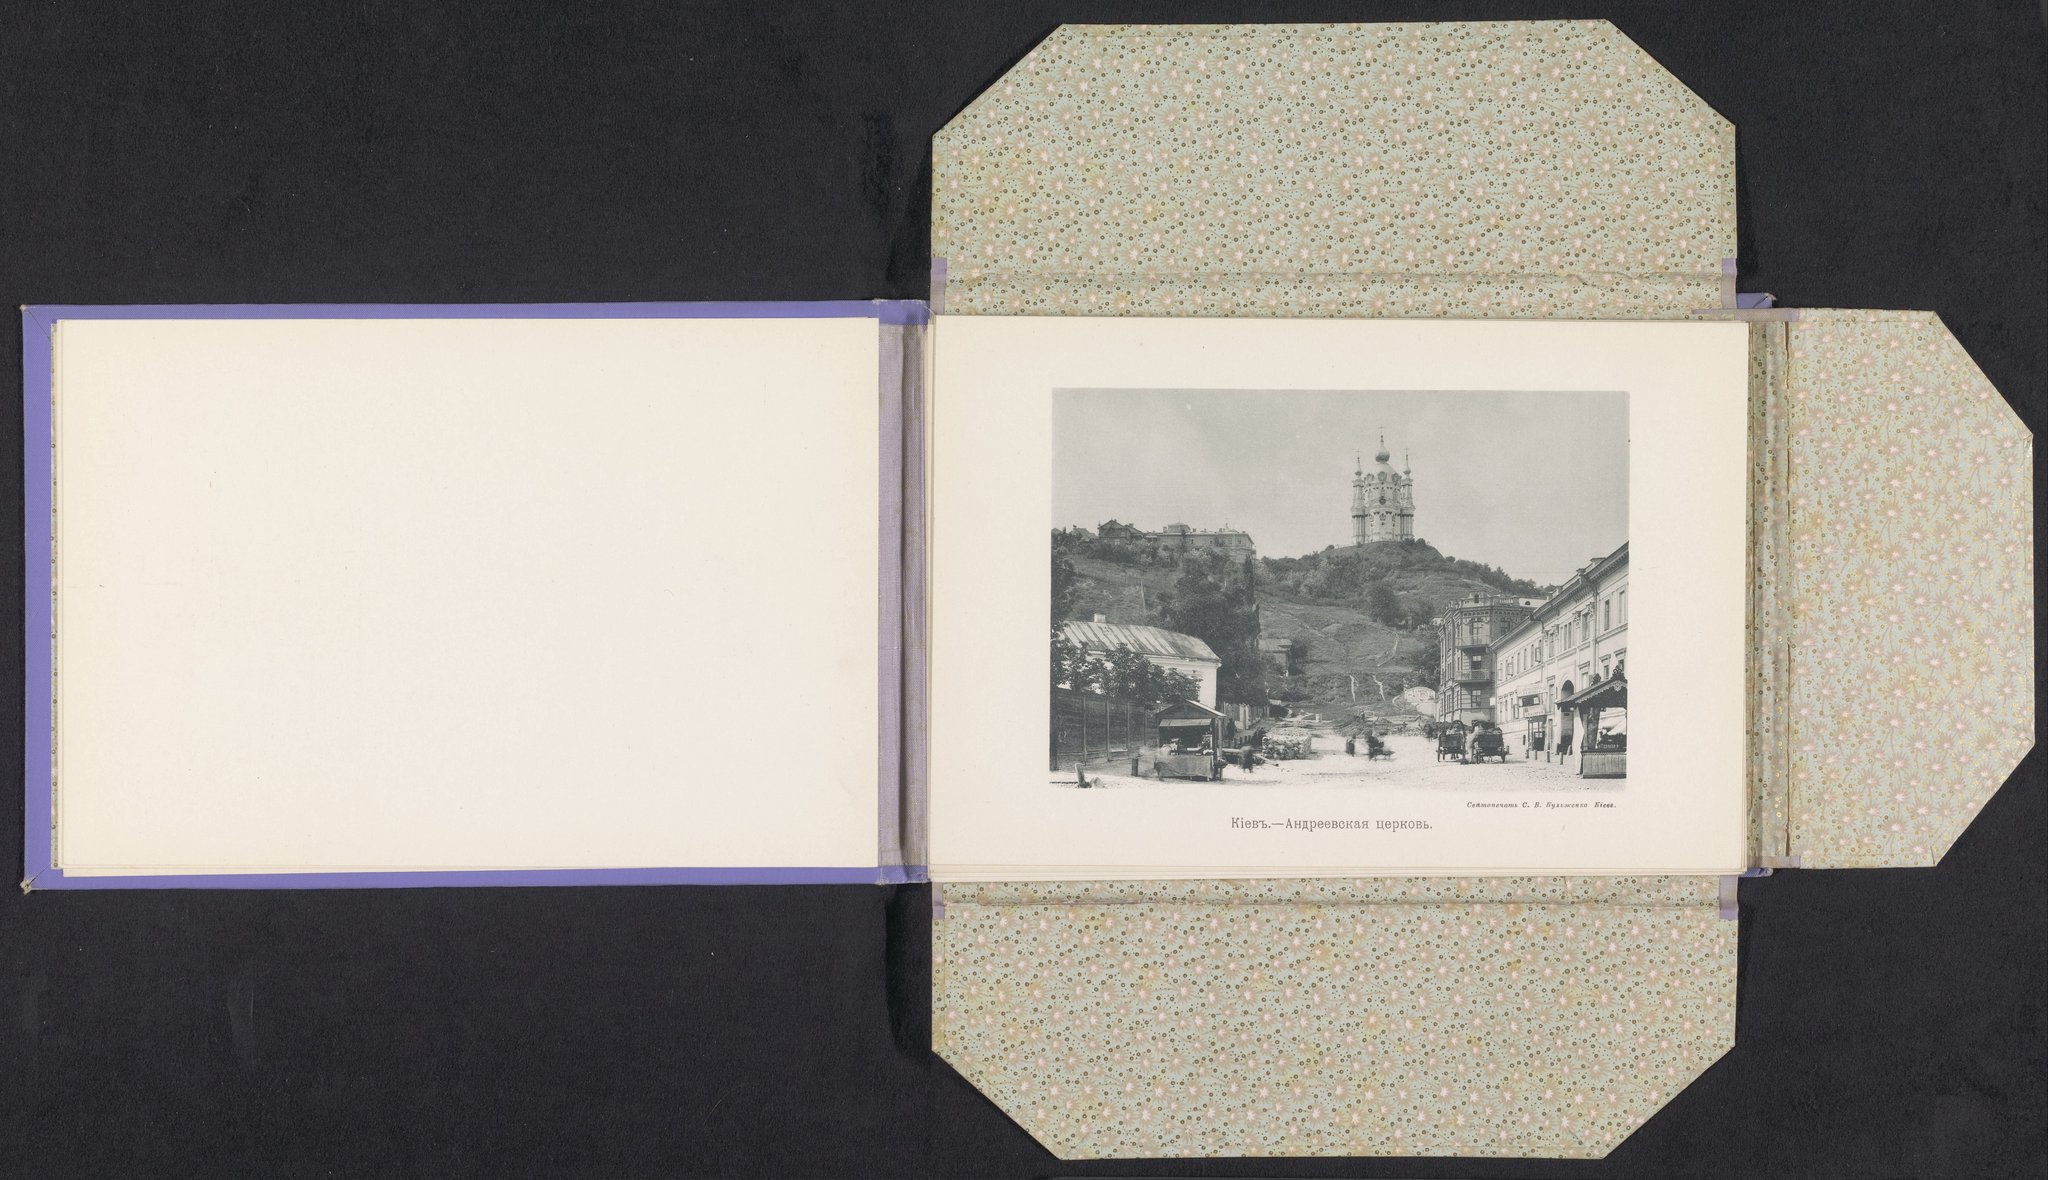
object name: page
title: Kieвъ.-Андpeeвckaя цepkoвЬ.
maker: Anonymous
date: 1886-1896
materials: paper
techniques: photograph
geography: kyiv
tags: low hill country, church (exterior), façade (of house or building)